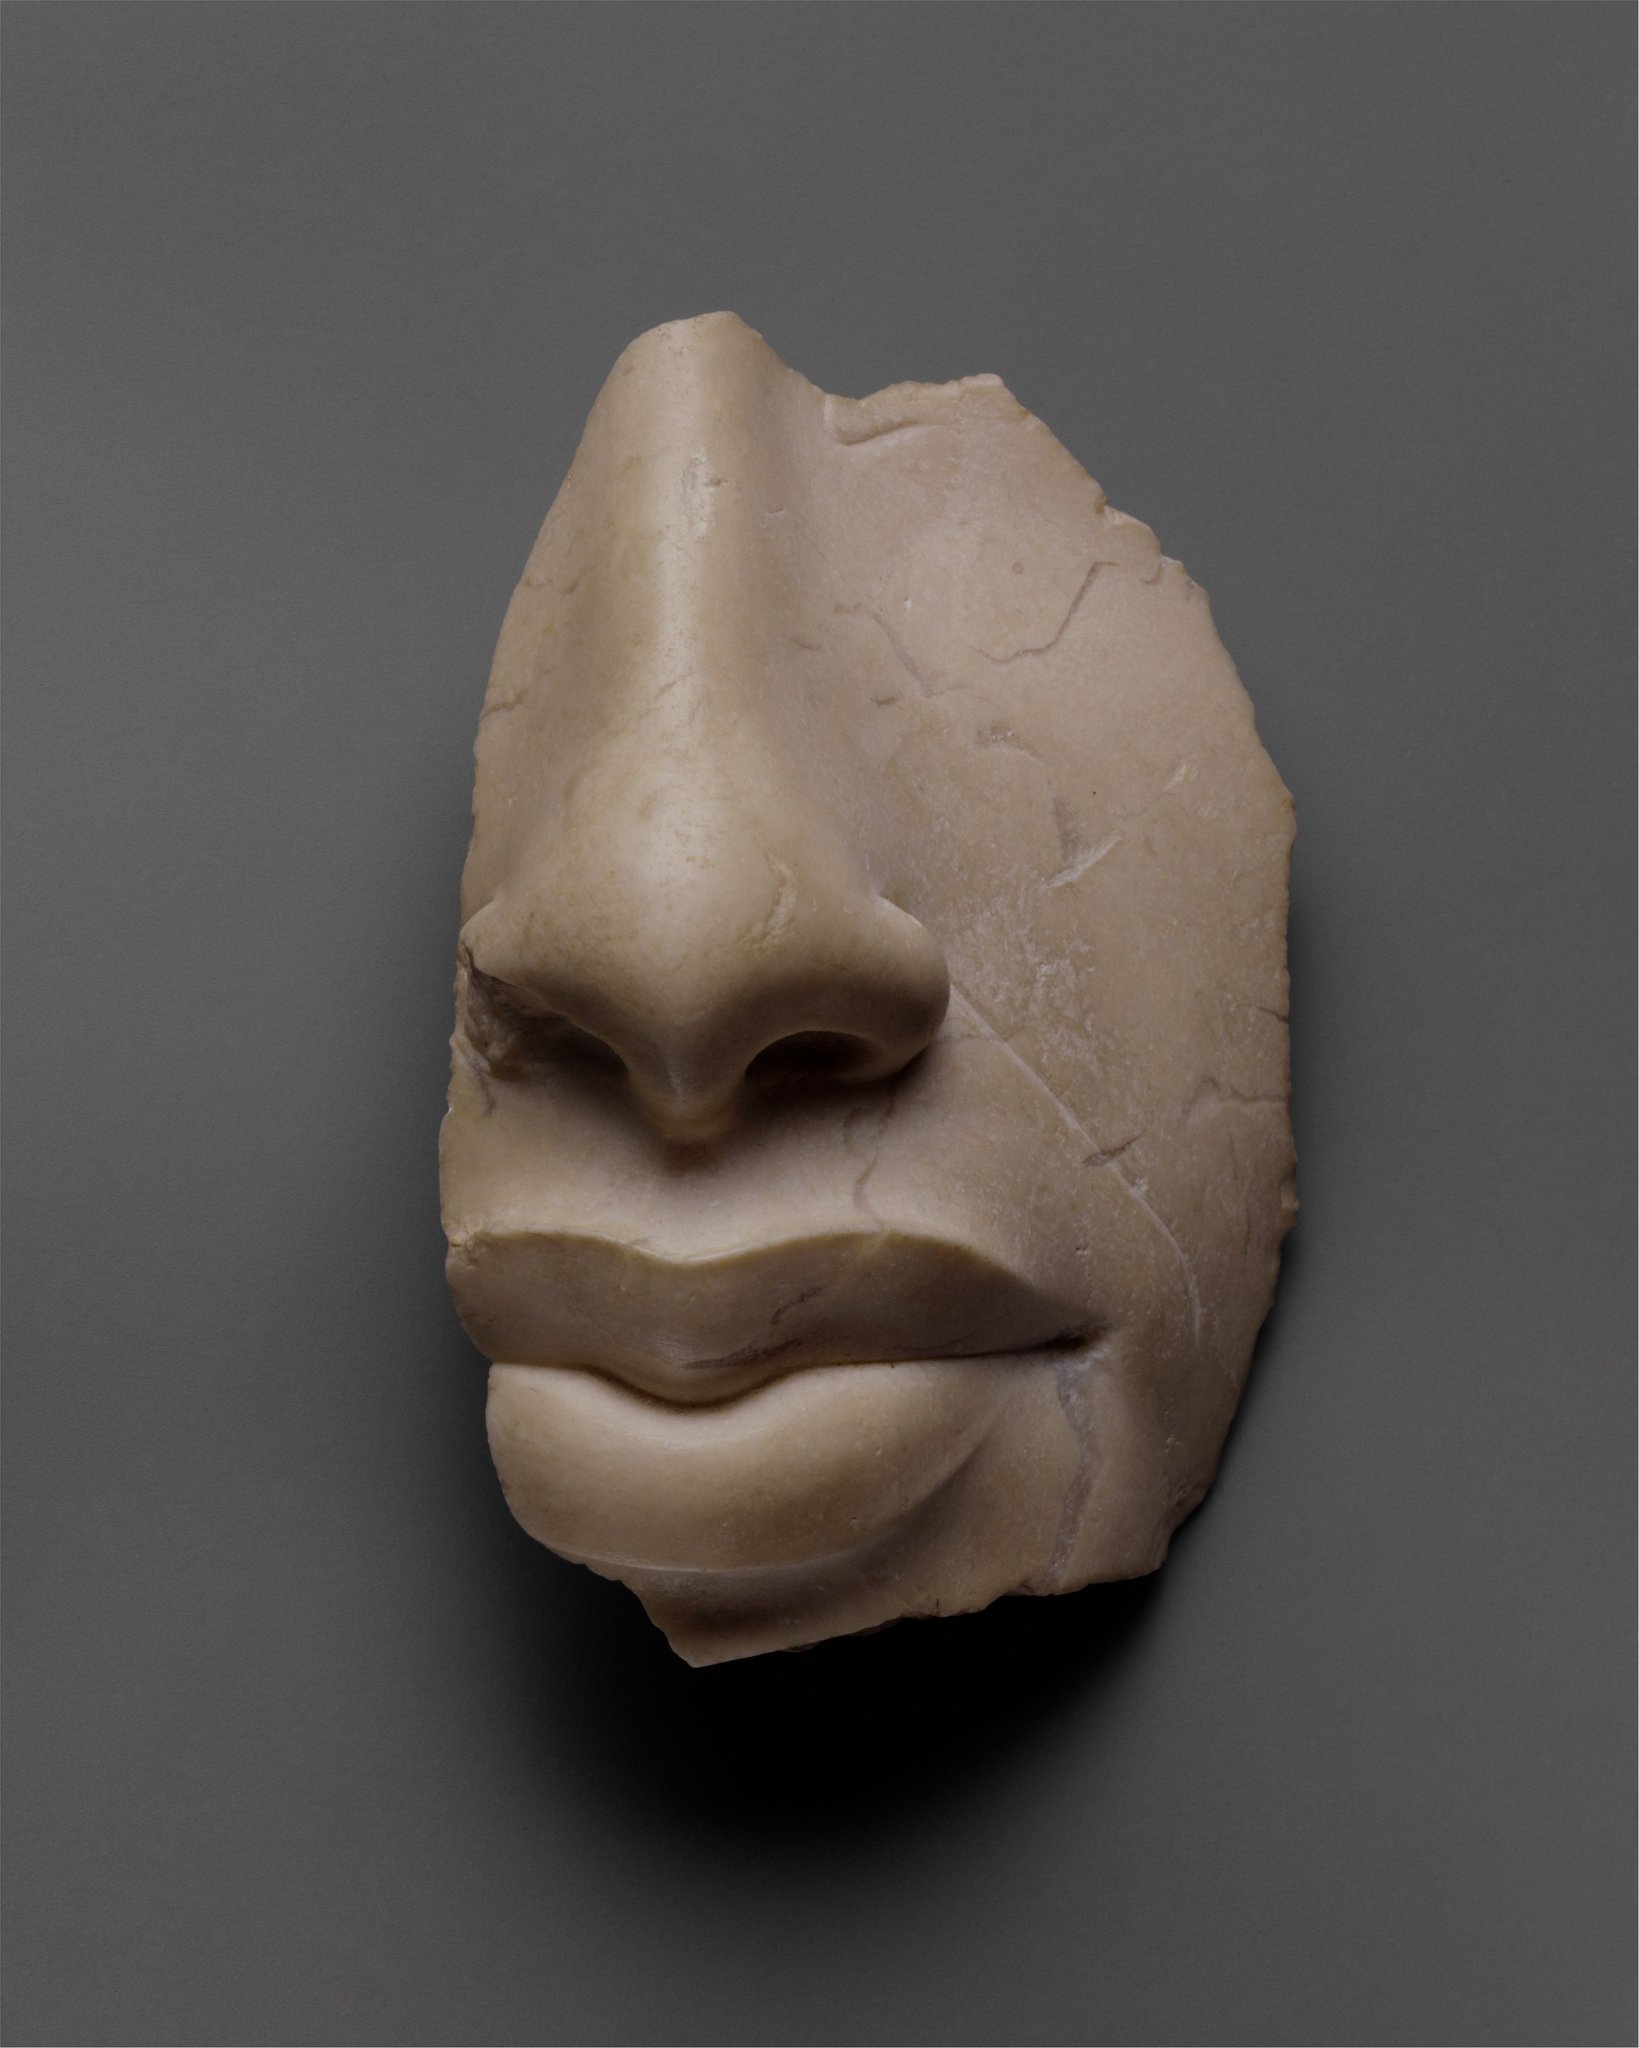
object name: akhenaten nose and lip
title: Nose and lips of Akhenaten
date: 1353-1336 BCE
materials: limestone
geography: egypt